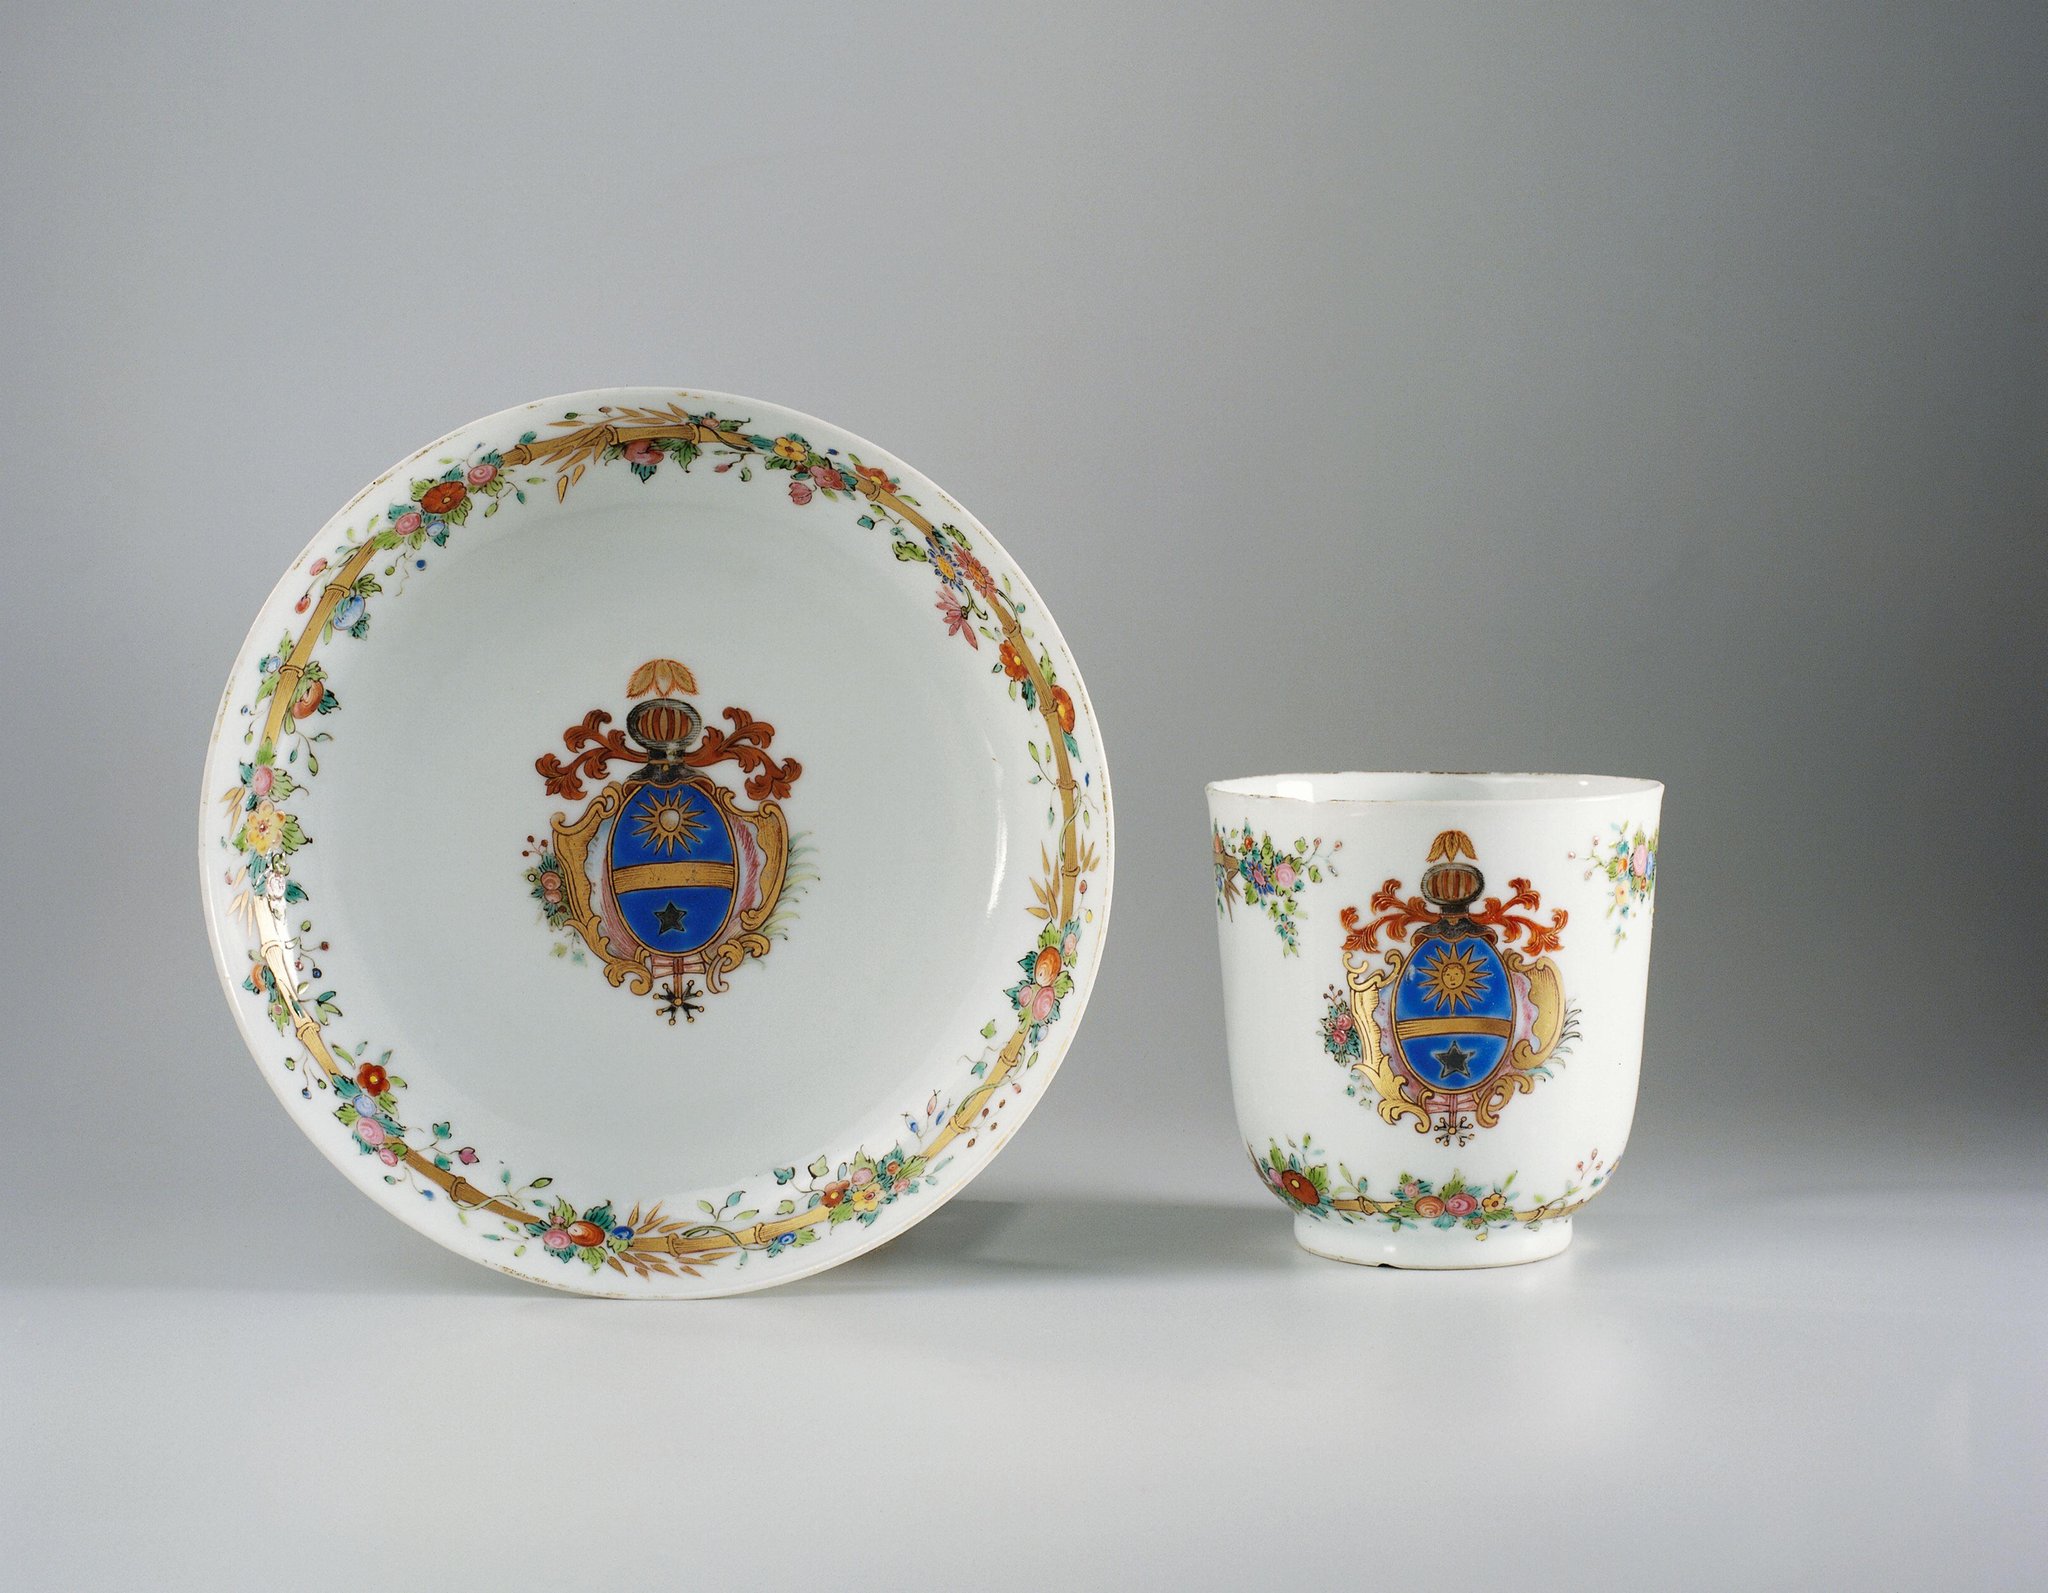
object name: platter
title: Saucer with a coat of arms and bamboo border with floral scrolls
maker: Anonymous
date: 1750-1774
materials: glaze, gold, paint, porcelain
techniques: firing, gilding, turning, vitrification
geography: china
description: Schotel van porselein, beschilderd op het glazuur in blauw, rood, roze, groen, geel, zwart en goud. Op het plat van de schotel een ongeïdentificeerd familiewapen met een zon met een gezicht, een ster en een gouden balk op een blauwe achtergrond. Het wapen is omgeven door bladranken, een palmtak en bloemtak. Op de wand een bamboe band met bloemranken. Wapenporselein met emailkleuren.